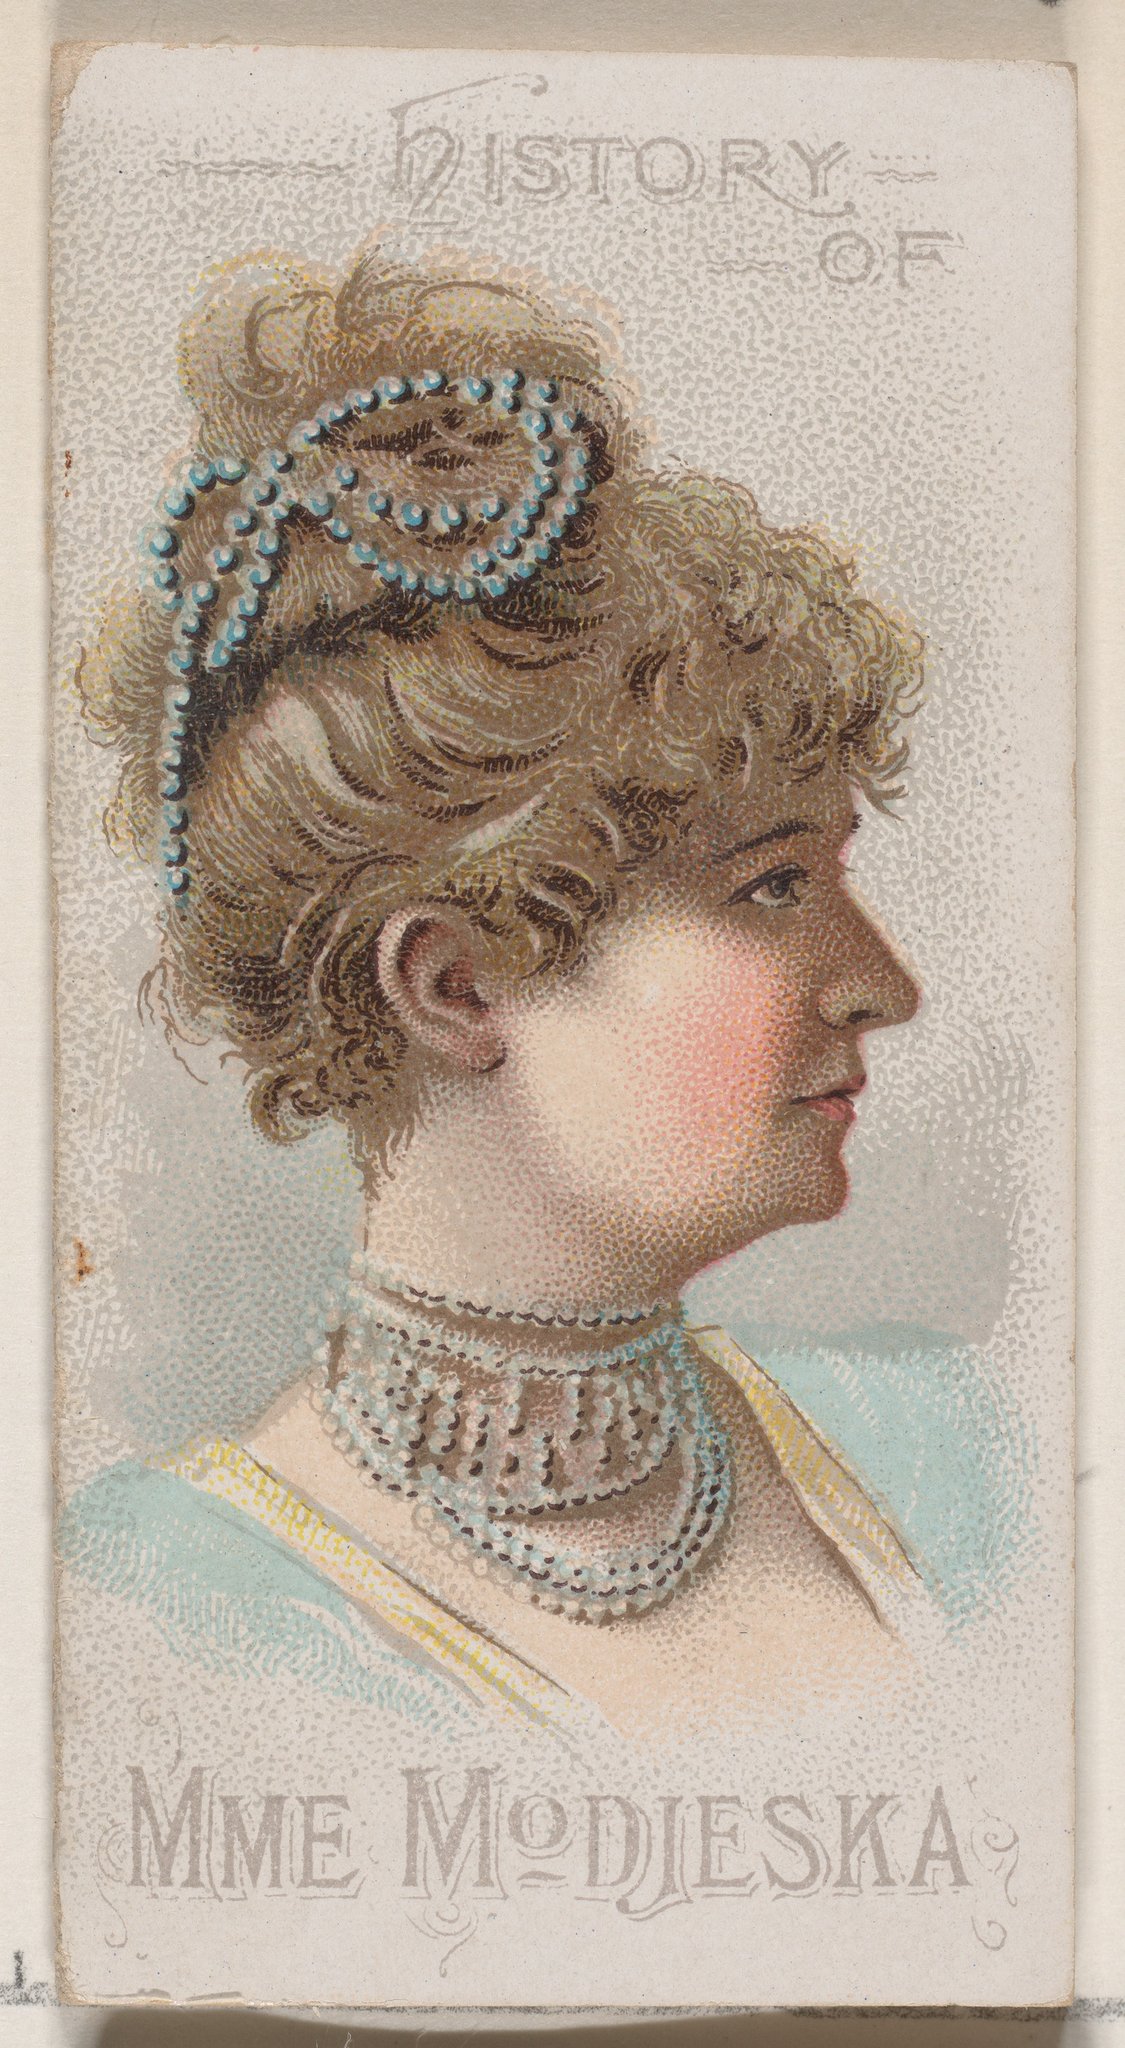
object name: print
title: History of Helena Modjeska, from the Histories of Poor Boys and Famous People series of booklets (N79) for Duke brand cigarettes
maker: w. duke, sons & co.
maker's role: publisher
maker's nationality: american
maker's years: 1870-1920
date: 1888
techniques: color lithograph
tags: women